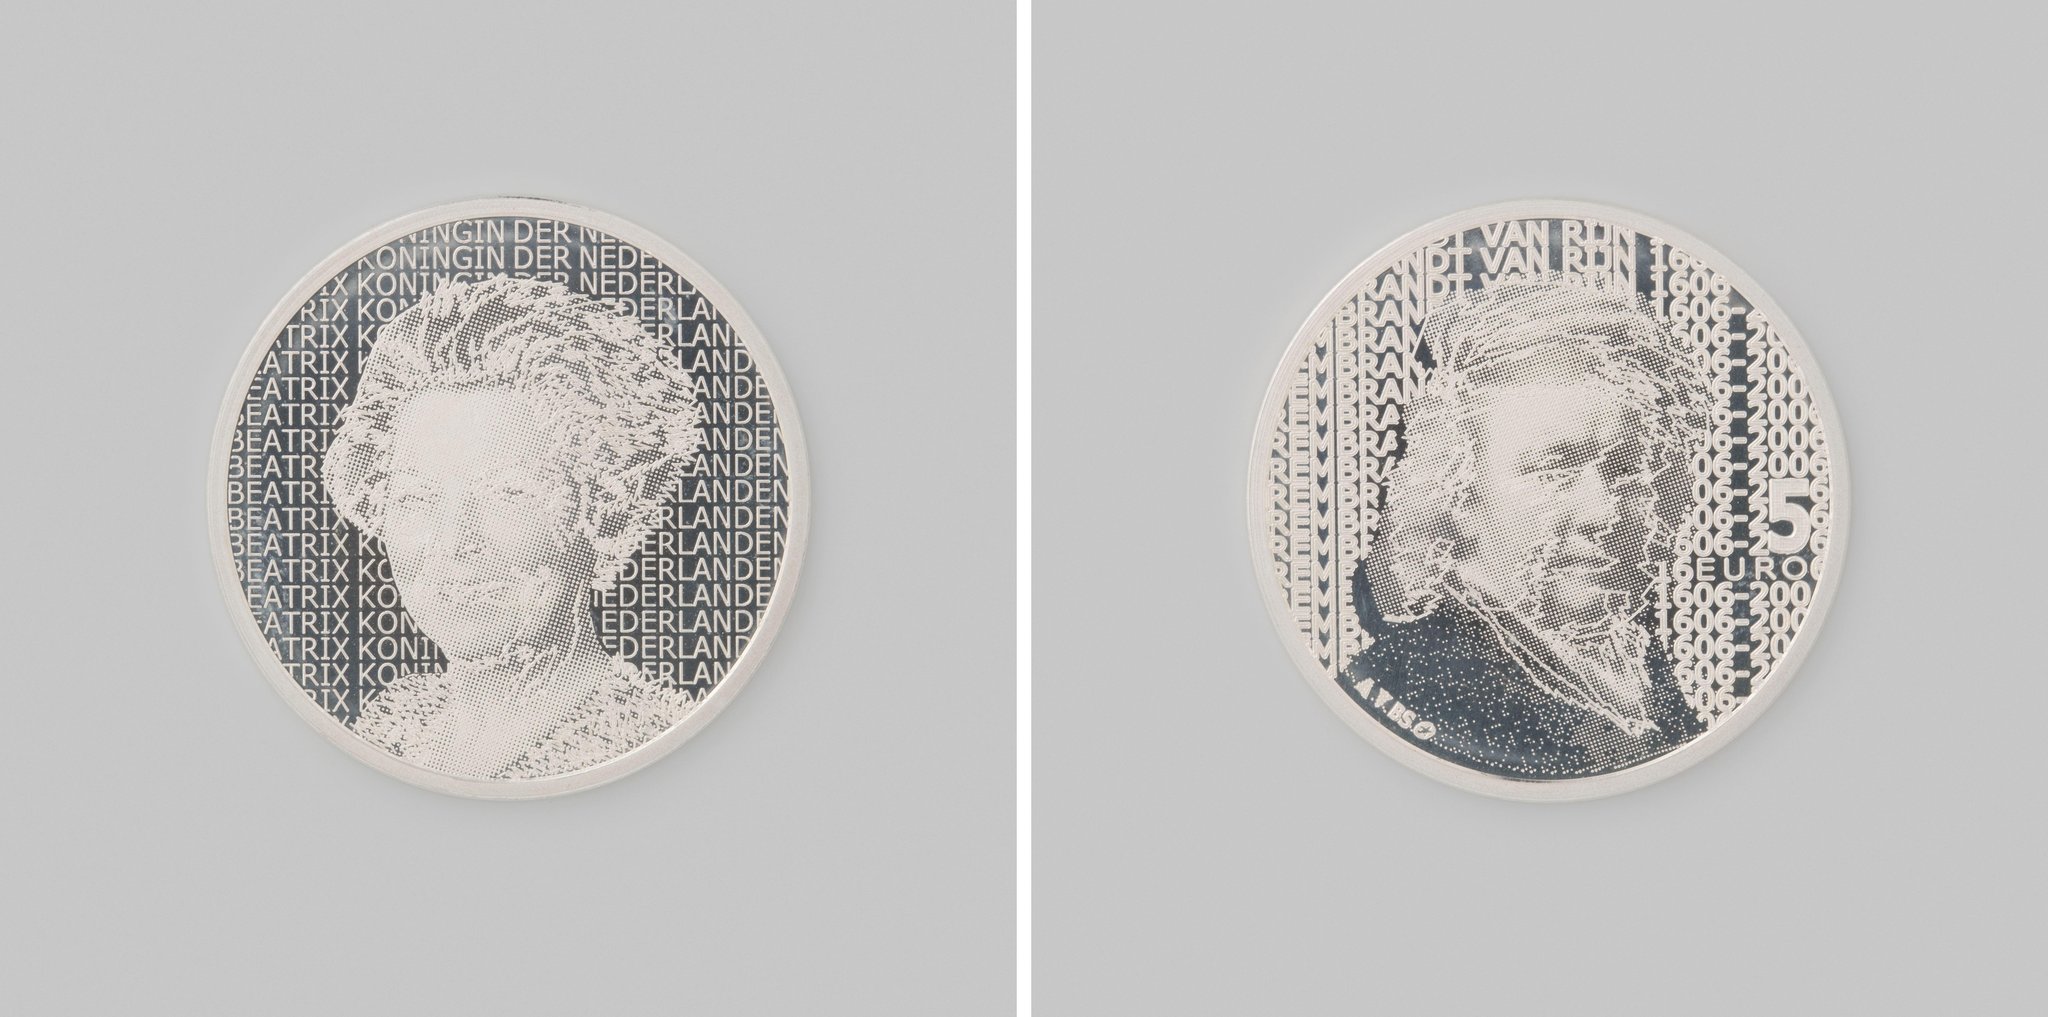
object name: coin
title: Eerste slag : Het Rembrandt Vijfje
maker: berend strik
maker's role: painter, sculptor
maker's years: 1960-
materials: silver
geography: netherlands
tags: leiden, amsterdam, painter, print maker, draughtsman, rembrandt van rijn, beatrix (koningin der nederlanden), netherlands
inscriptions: inscription: ‘5 EURO’, edge inscription: ‘GOD ZIJ MET ONS’, inscription: ‘REMBRANDT VAN RIJN 1606-2006’, inscription: ‘BEATRIX KONINGIN DER NEDERLANDEN’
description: Zilveren munt van vijf Euro. Voorzijde: portret van koningin Beatrix half naar links gewend, geplaatst op herhaald opschrift. Keerzijde: portret van Rembrandt, geplaatst op herhaald opschrift, met nominale waarde en merken. Randschrift. Voor de portretten zijn diverse technieken gecombineerd: op een gelaserde foto zijn lijnen van borduursel gemodelleerd. Munt gevat in perspex. Bijbehorend houten doosje met inleg.